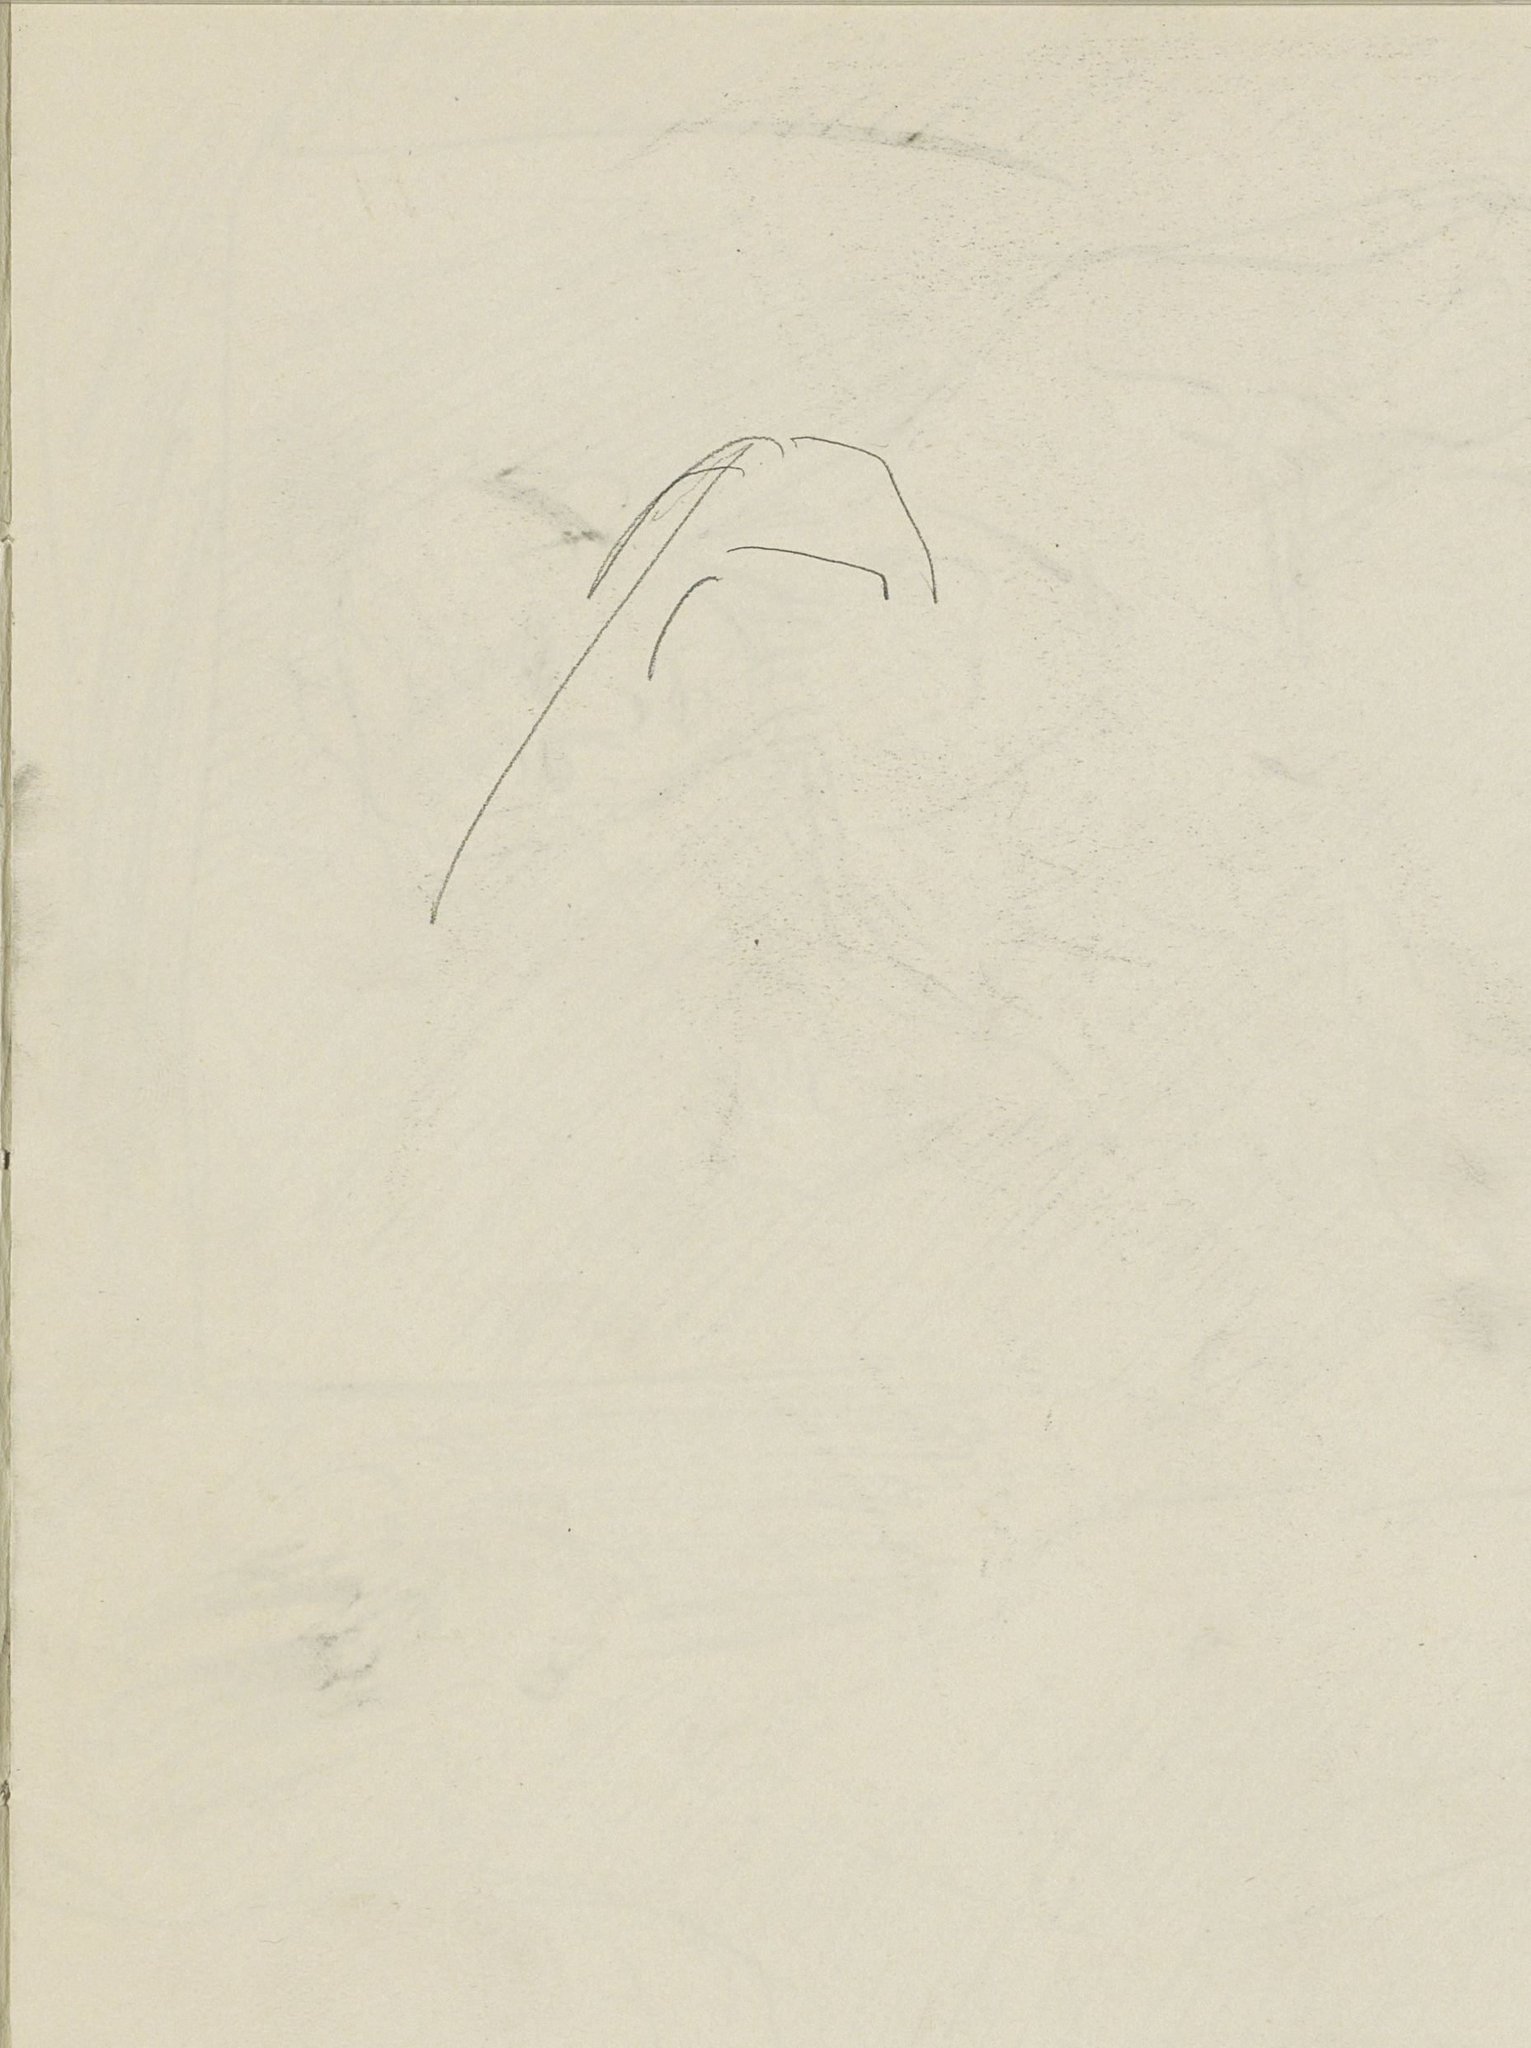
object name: sketchbook leaf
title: Studie, mogelijk van een hoofddoek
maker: isaac israels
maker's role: draughtsman, painter, print maker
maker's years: 1865-1934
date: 1875-1934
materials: paper, pencil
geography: the hague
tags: veil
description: Blad 4 recto uit schetsboek XXIV met 10 bladen.